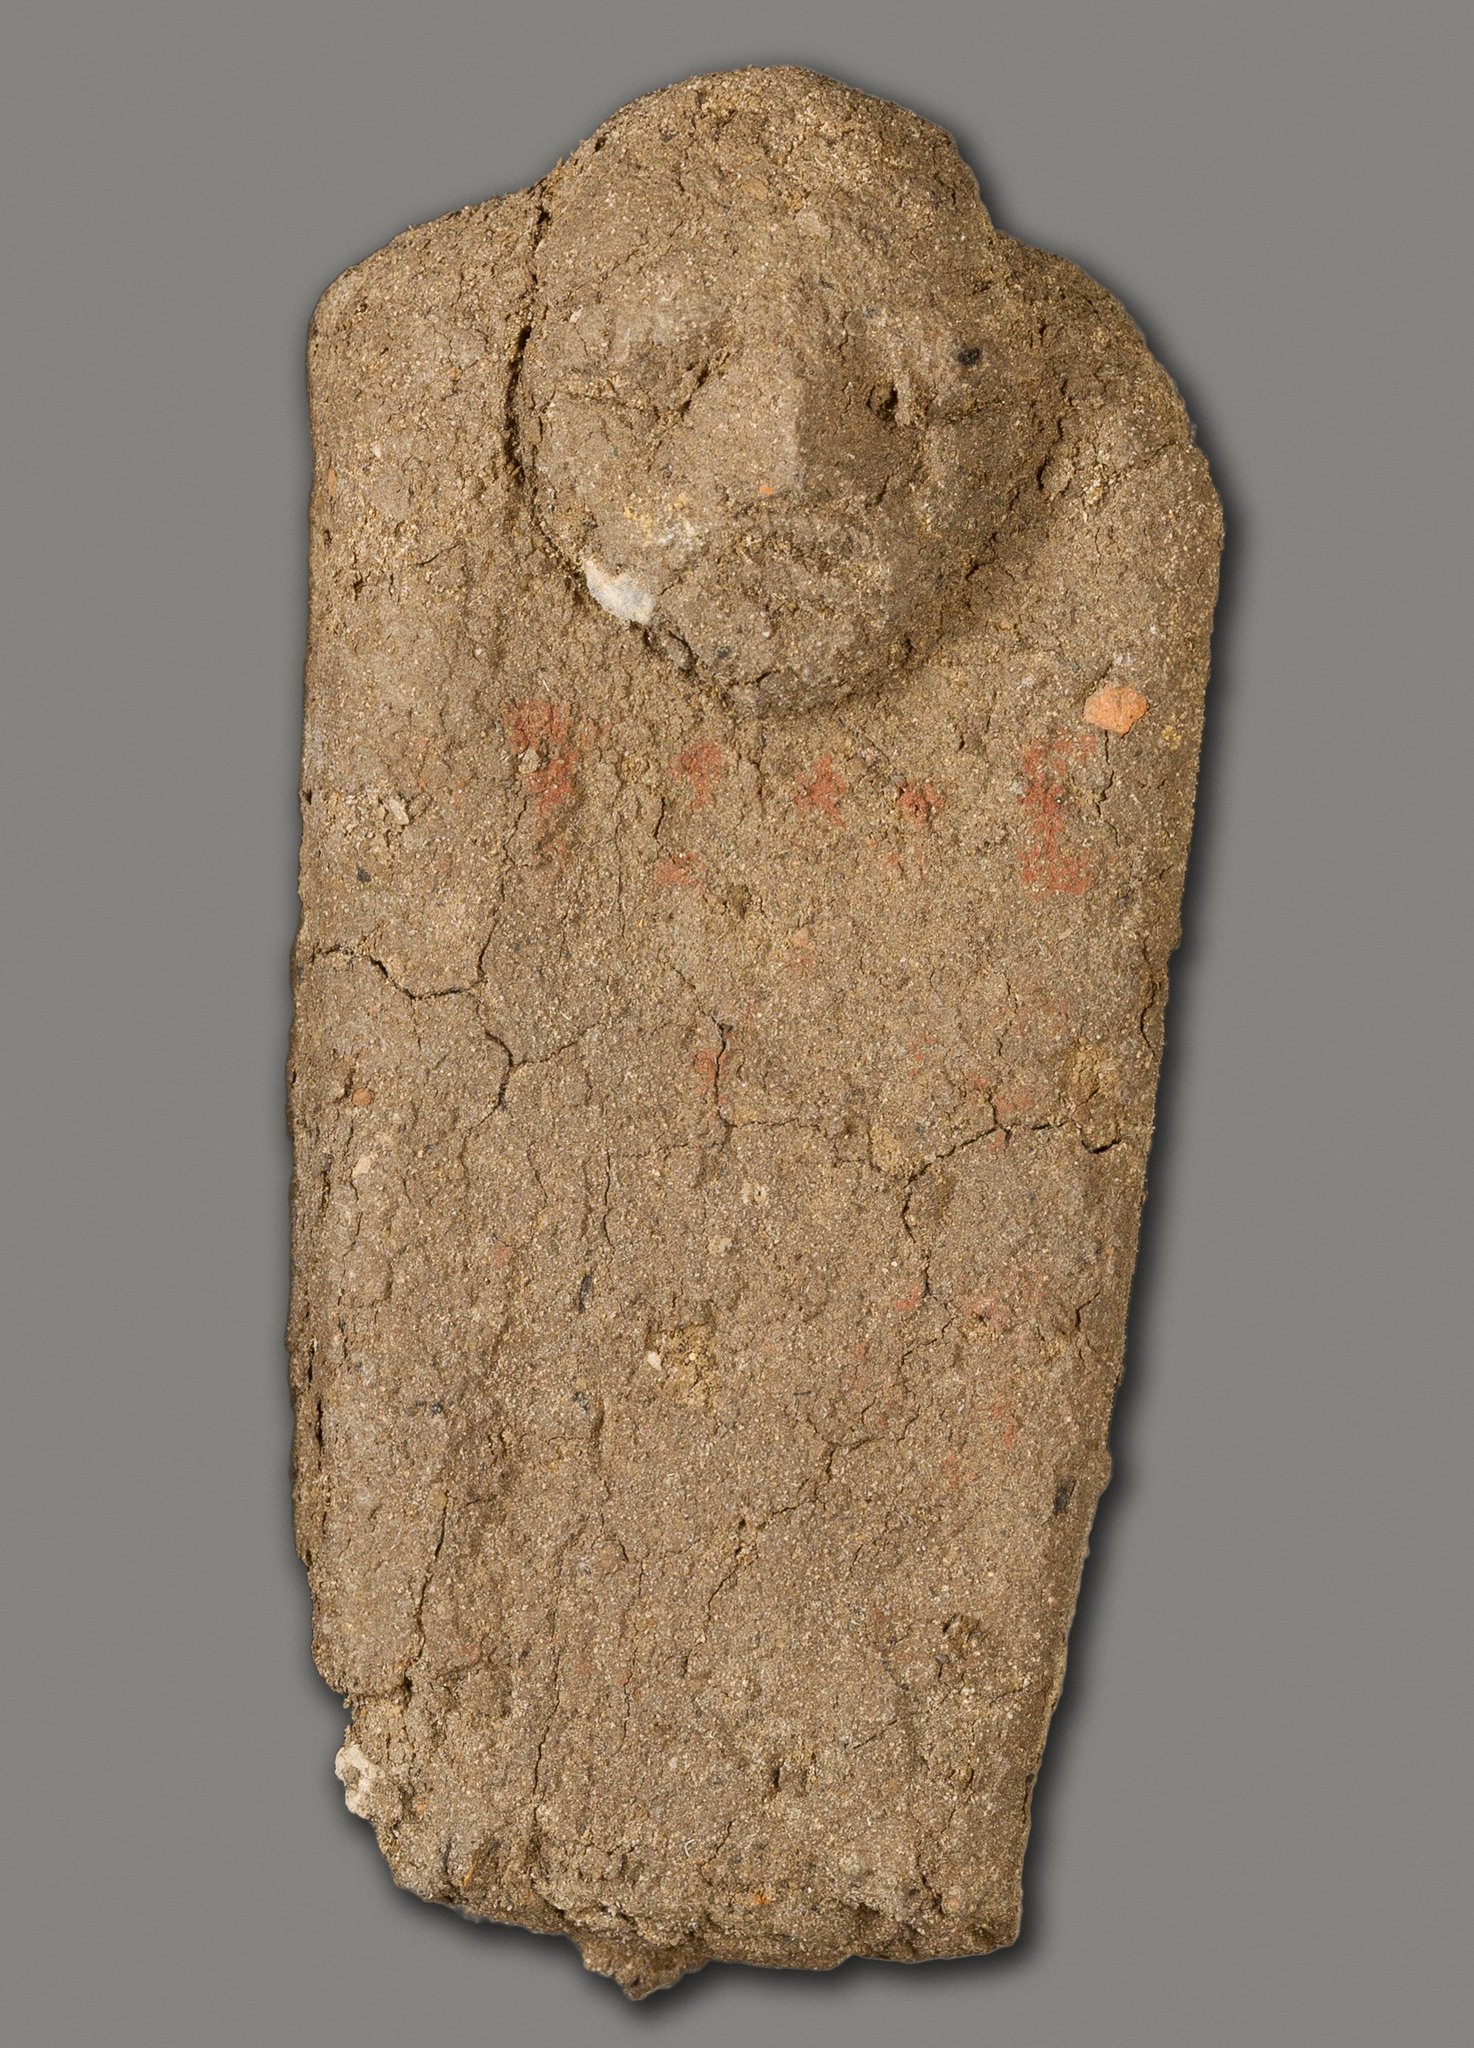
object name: figure, magical, execration, tablet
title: Magical Figure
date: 1802-1550 BCE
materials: clay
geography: egypt